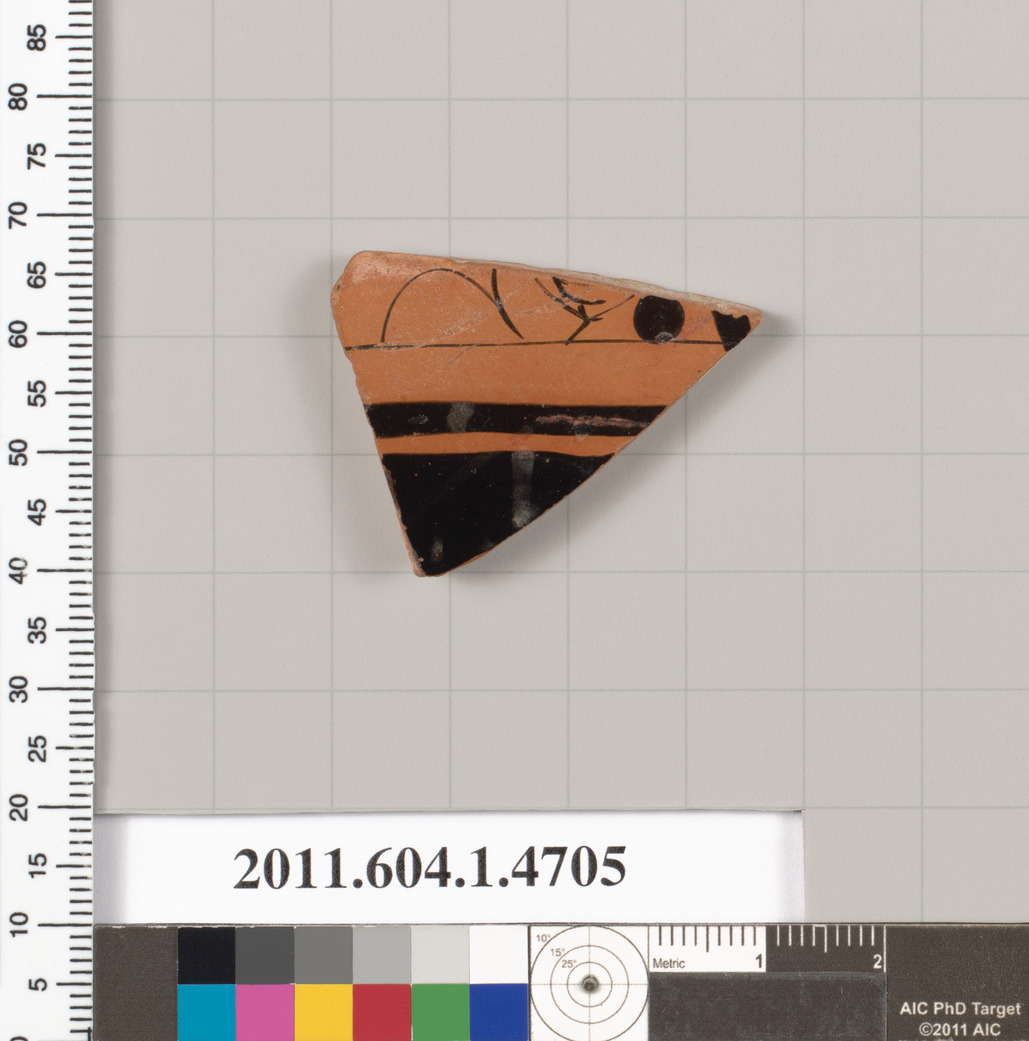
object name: kylix fragment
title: Terracotta fragment of a kylix (drinking cup)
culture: greek, attic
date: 475-451 BCE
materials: terracotta